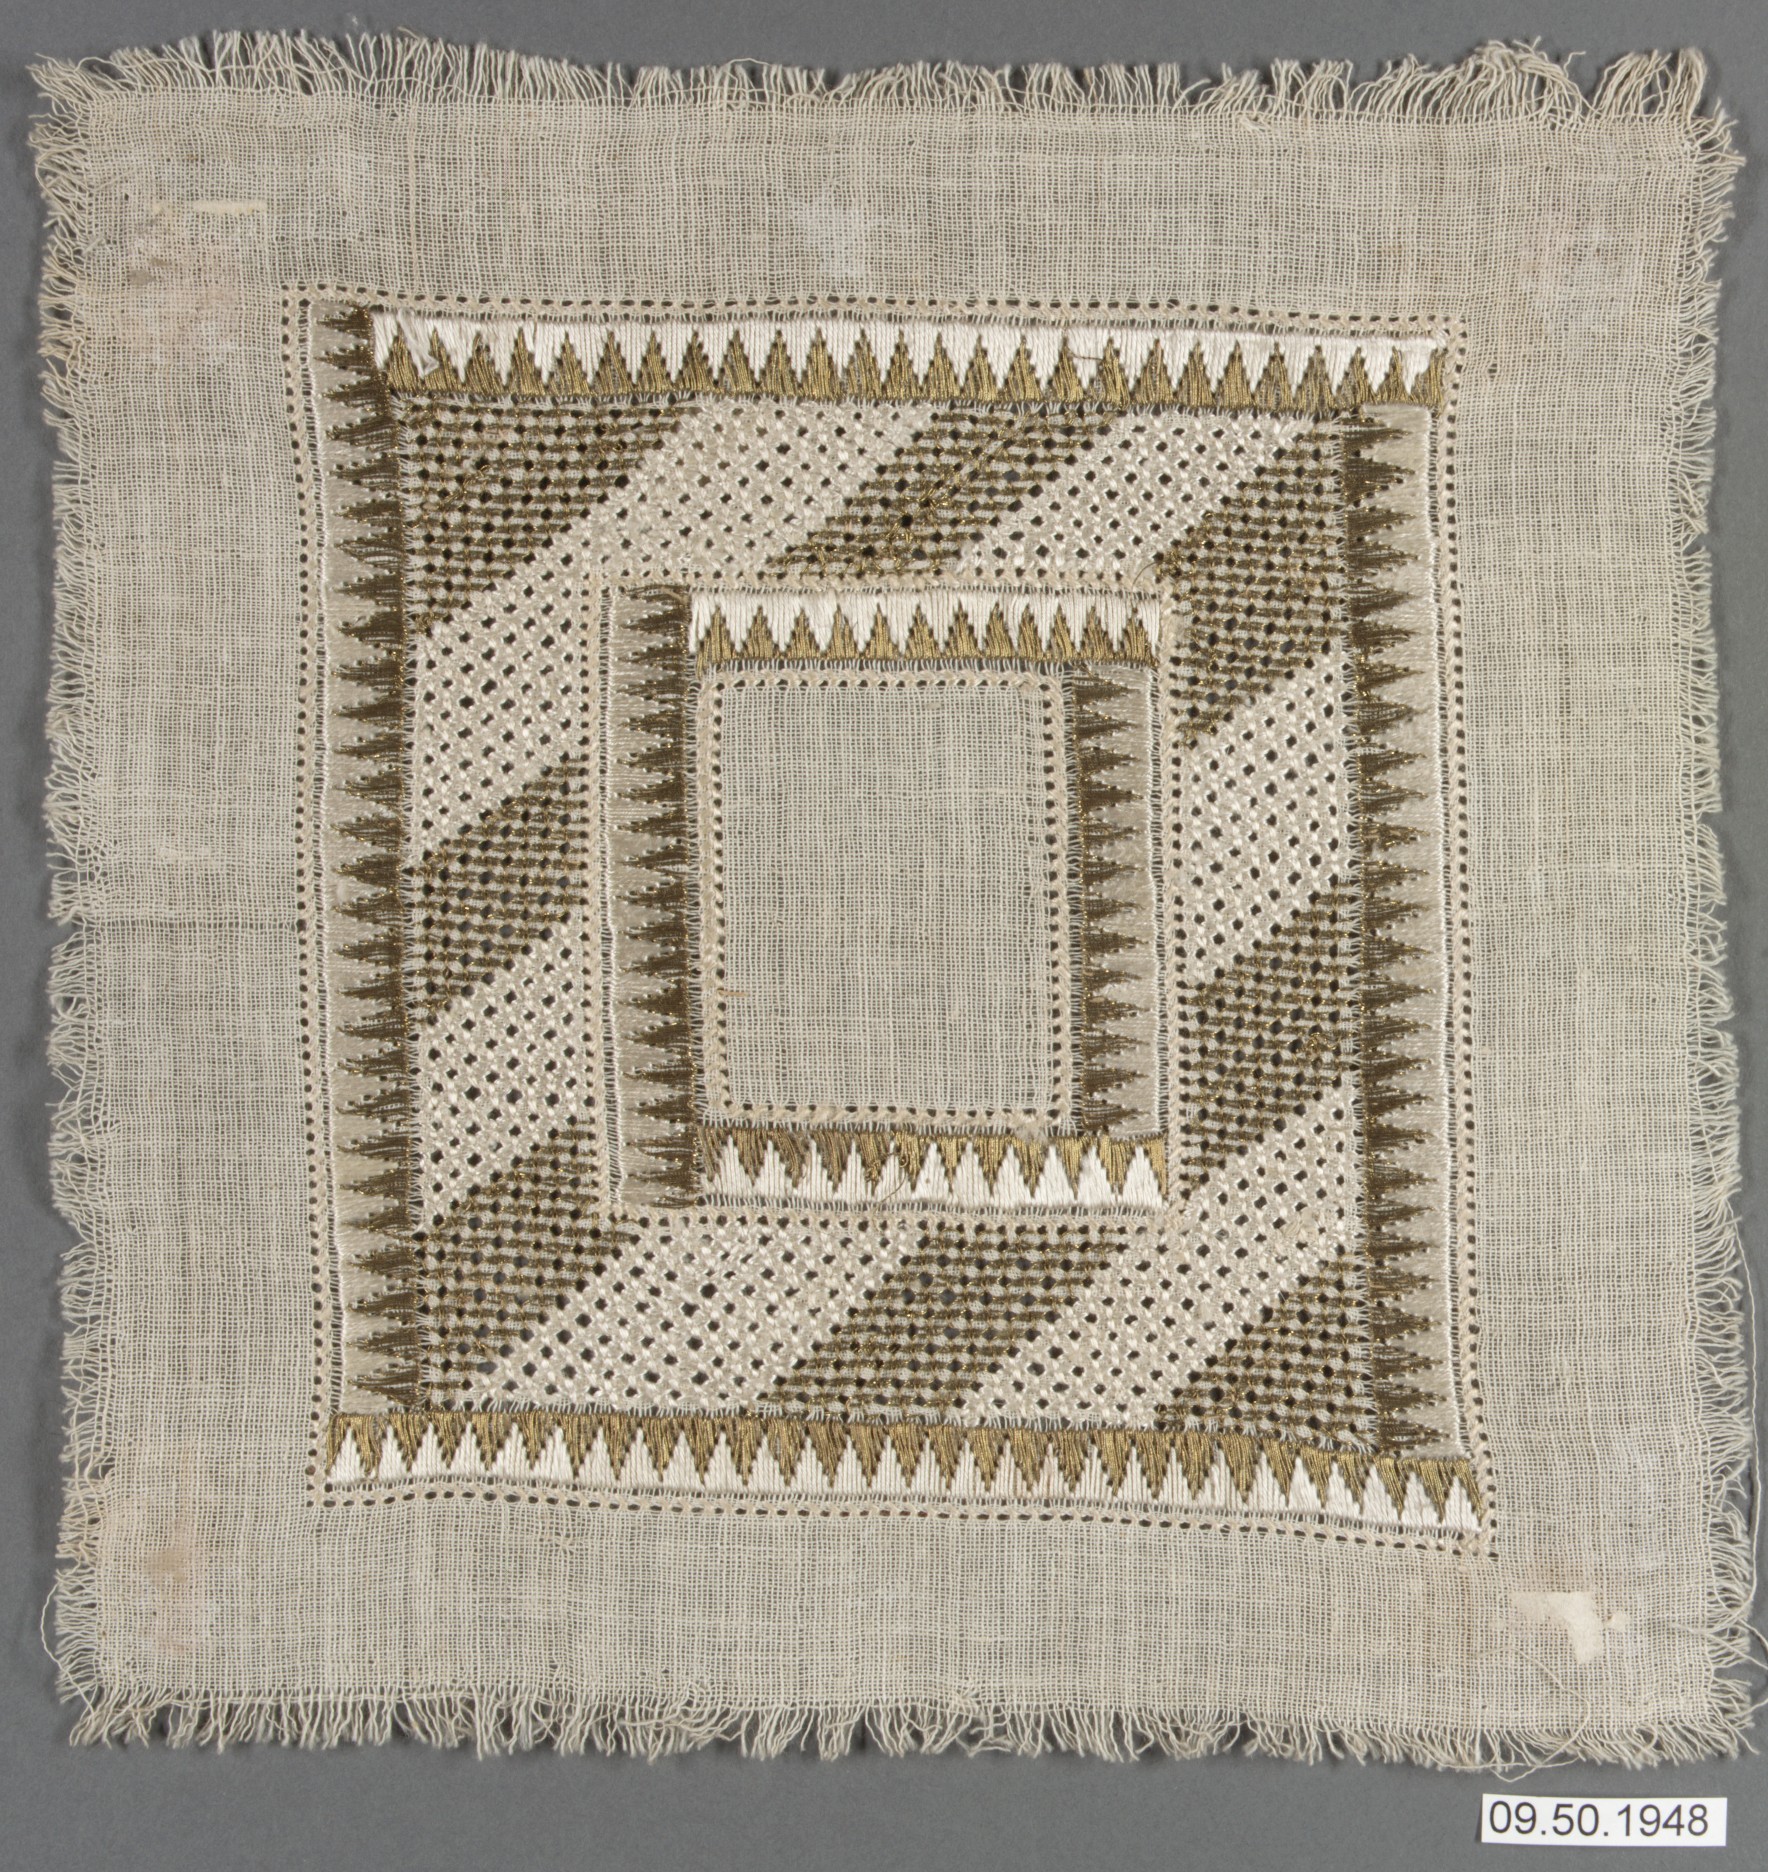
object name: square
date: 1801-1900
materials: cotton, metal thread, silk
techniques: embroidery, weave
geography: turkey